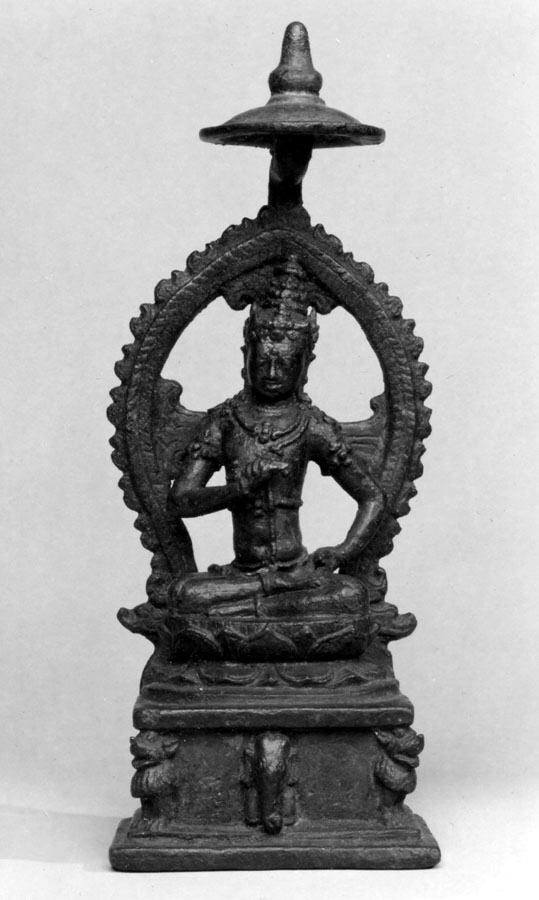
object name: figure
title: Seated Bodhisattva Vajrasattva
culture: indonesian, javanese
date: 901-925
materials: bronze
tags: buddhism,bodhisattvas